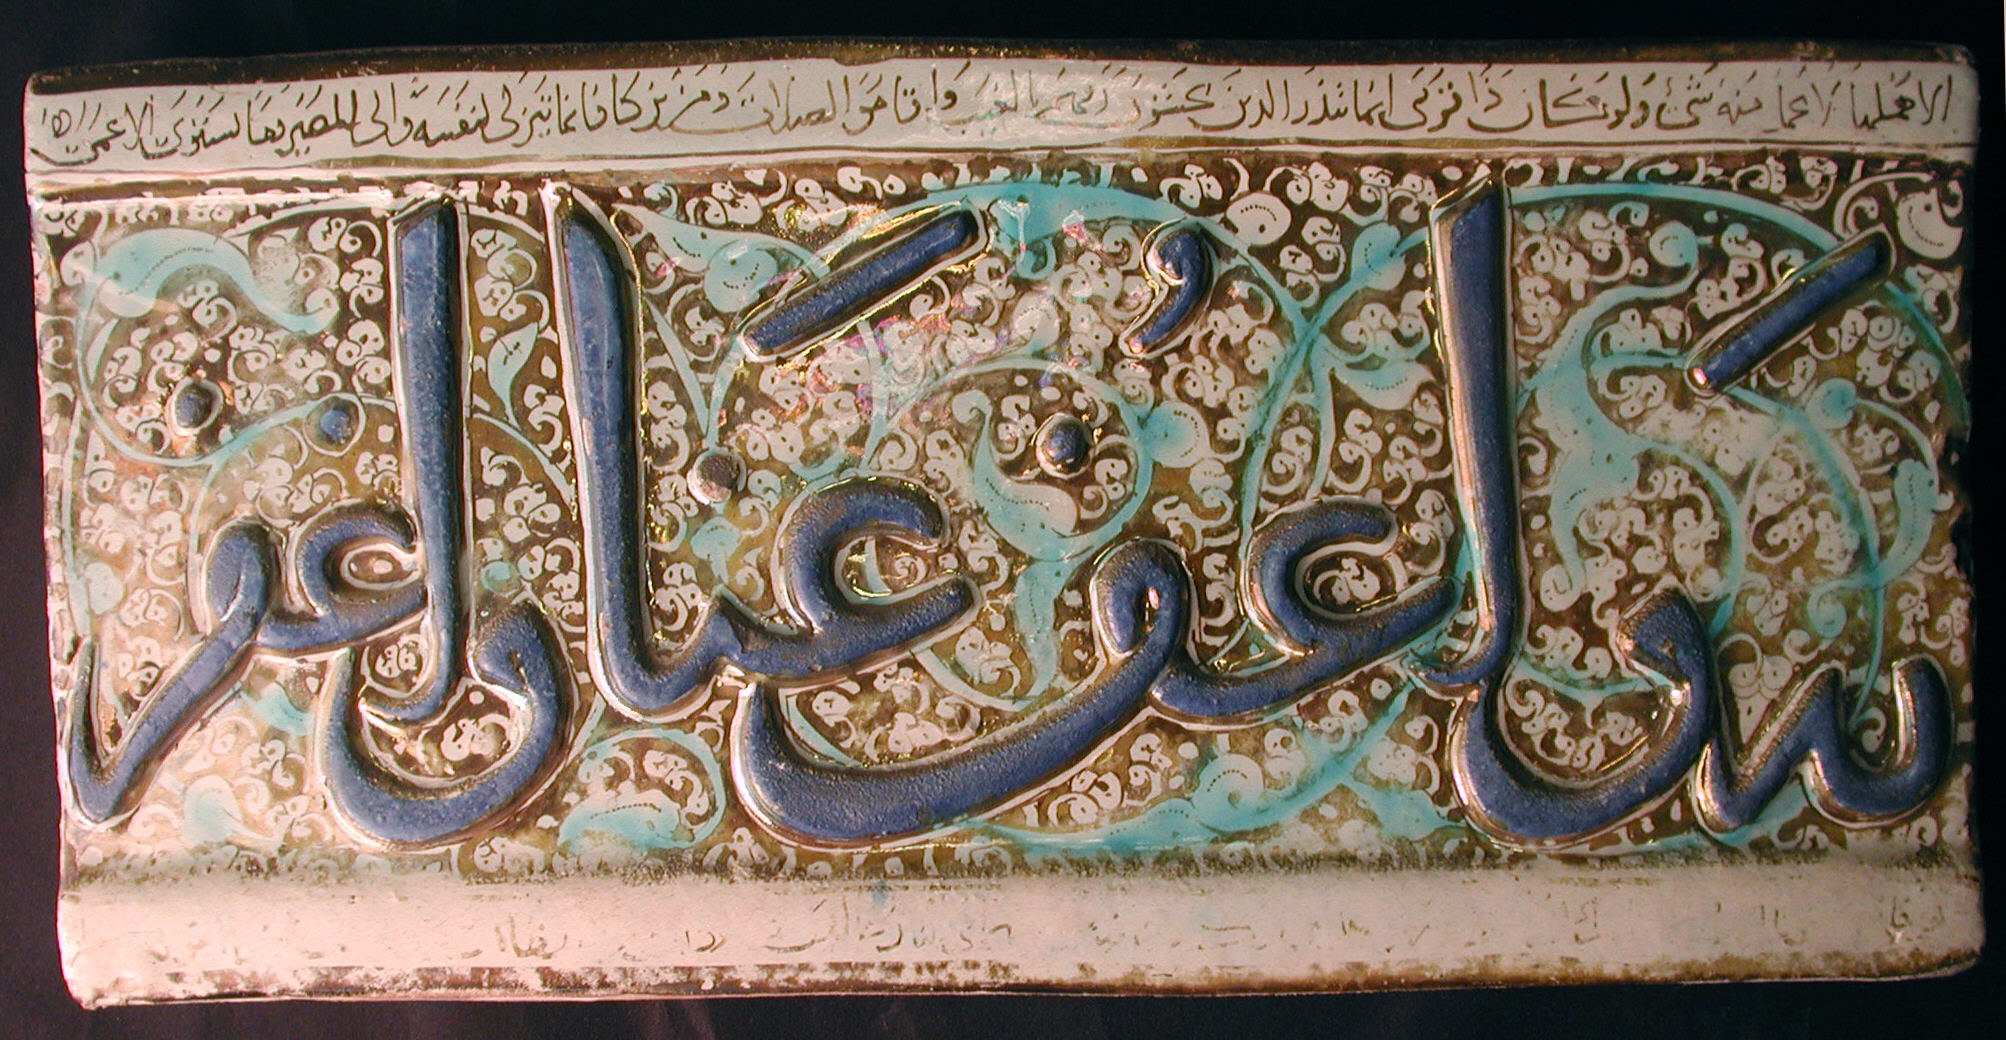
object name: tile from a frieze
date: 1301-1333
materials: glaze, stonepaste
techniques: luster painting, painting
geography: iran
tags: arabic